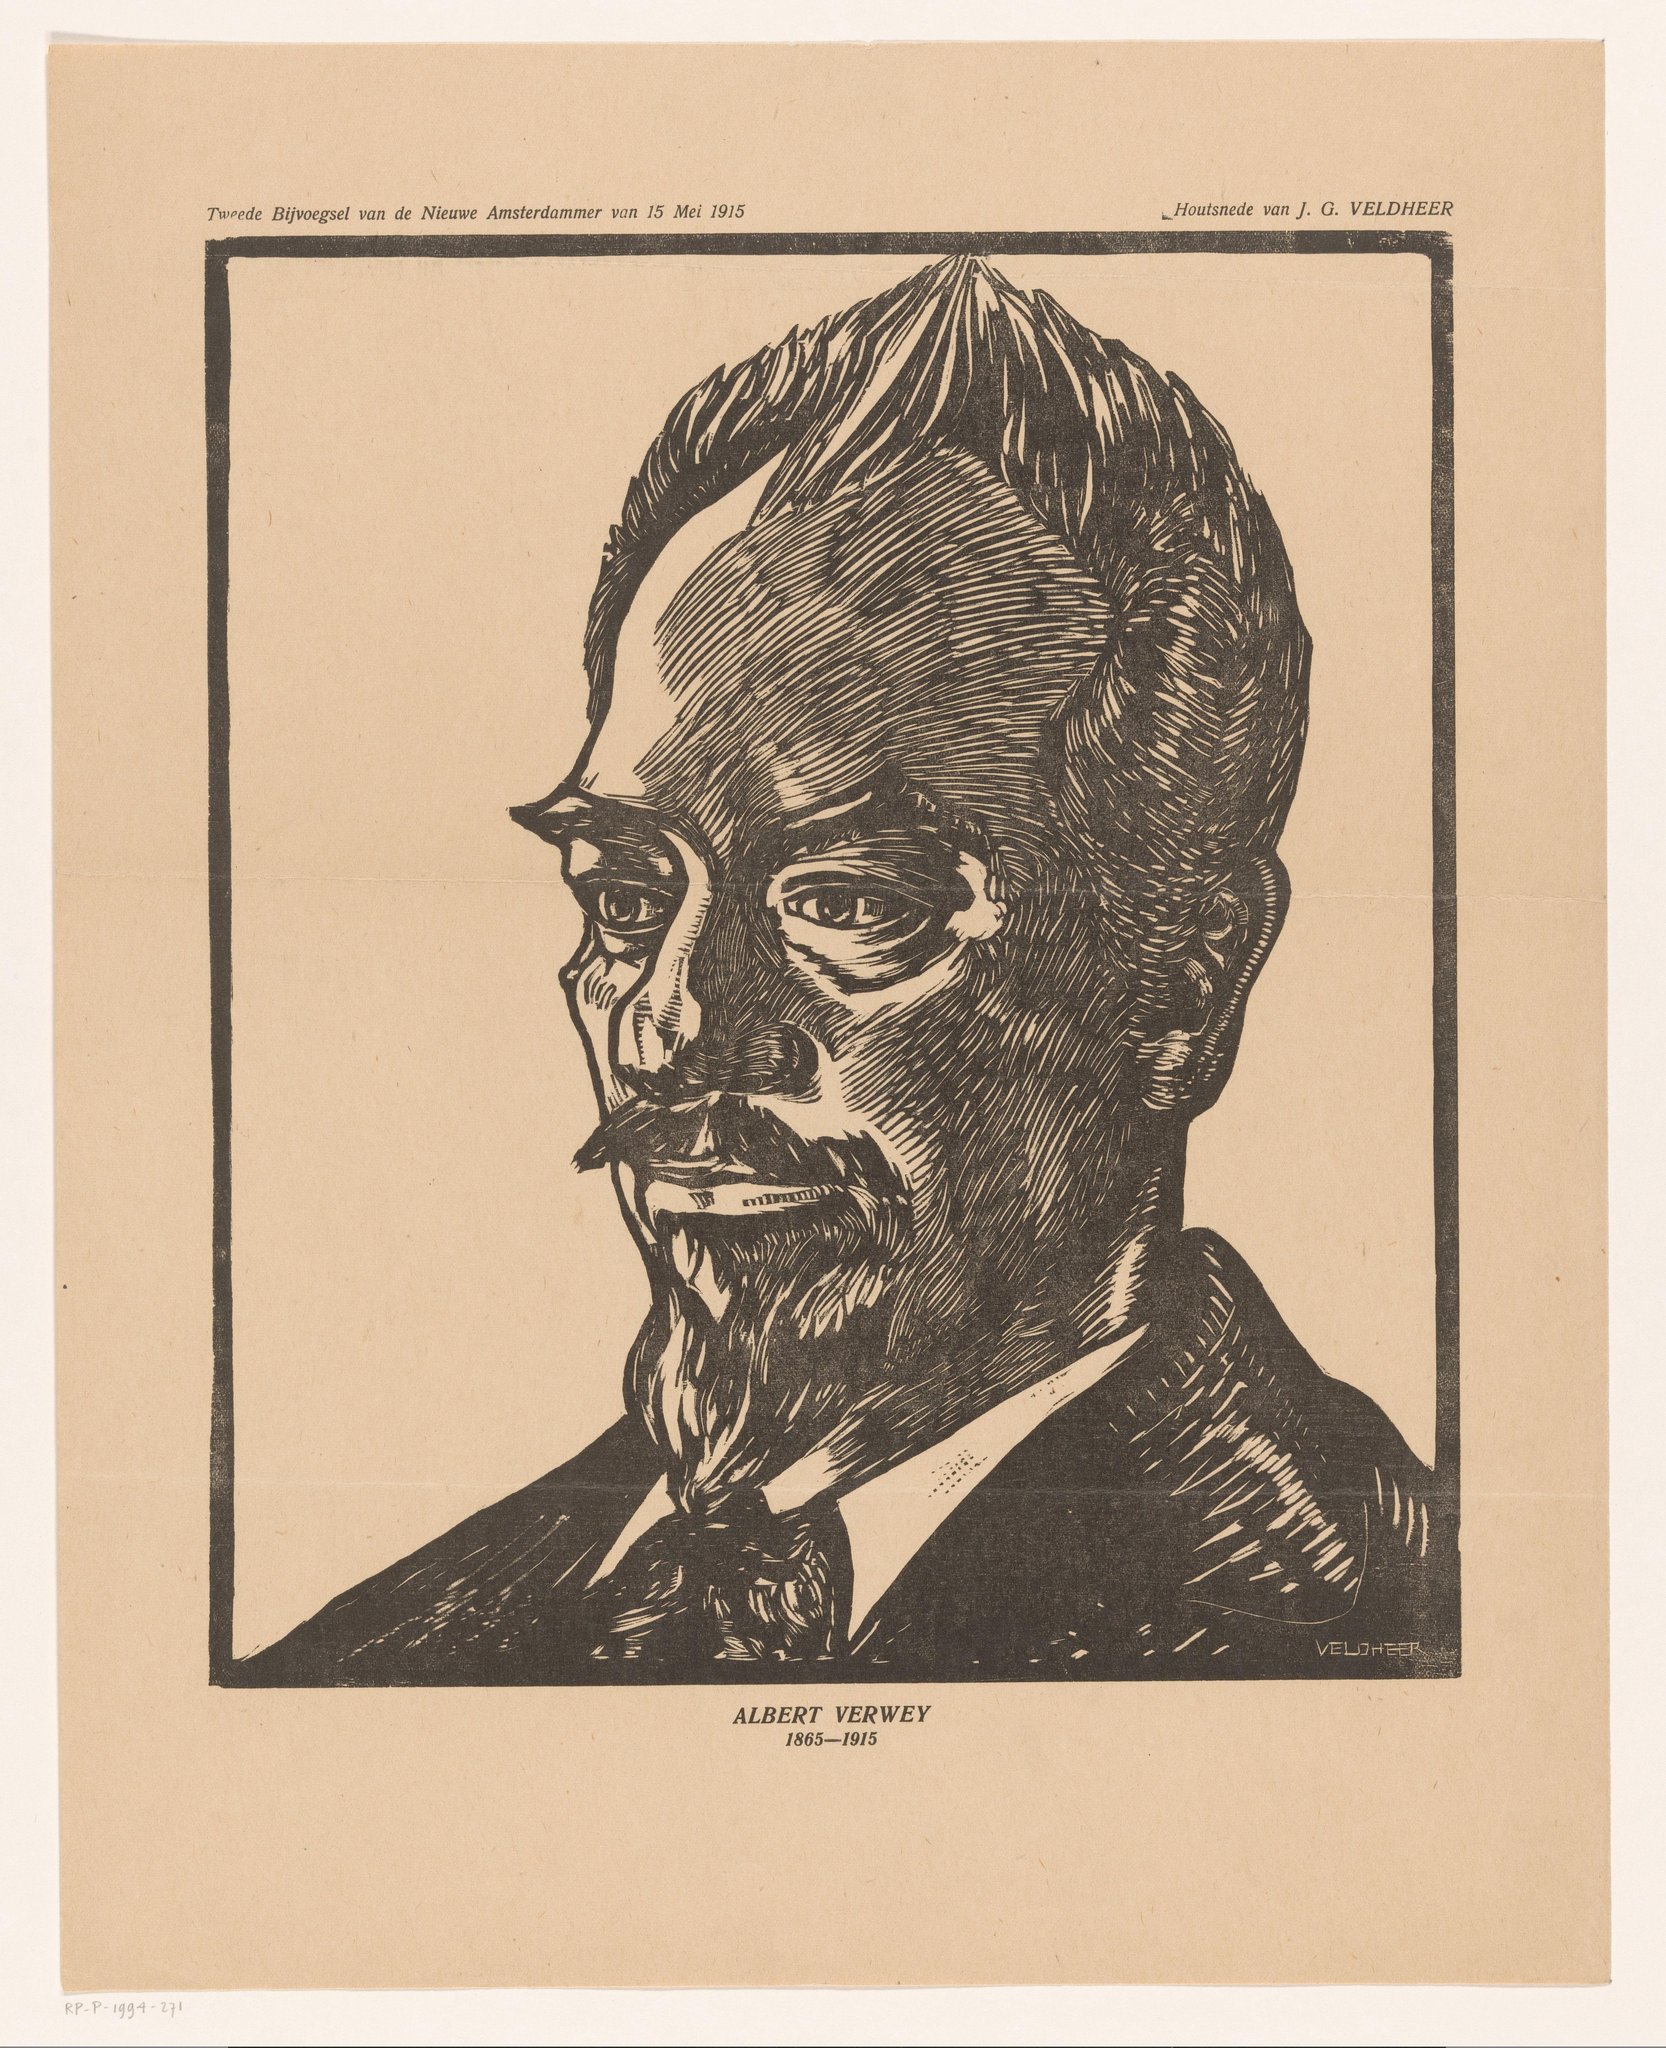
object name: print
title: Portret van Albert Verwey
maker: jacobus gerardus veldheer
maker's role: draughtsman, print maker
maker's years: 1866-1954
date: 1915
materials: paper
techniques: woodcut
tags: amsterdam, albert verwey, historical persons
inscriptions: inscription: ‘Tweede Bijvoegsel van de Nieuwe Amsterdammer van 15 Mei 1915’, collector's mark: Lugt 2228